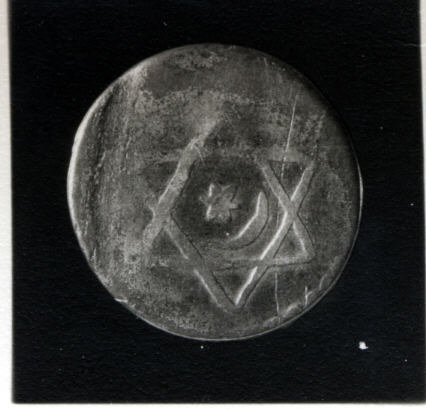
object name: coin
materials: copper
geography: iraq